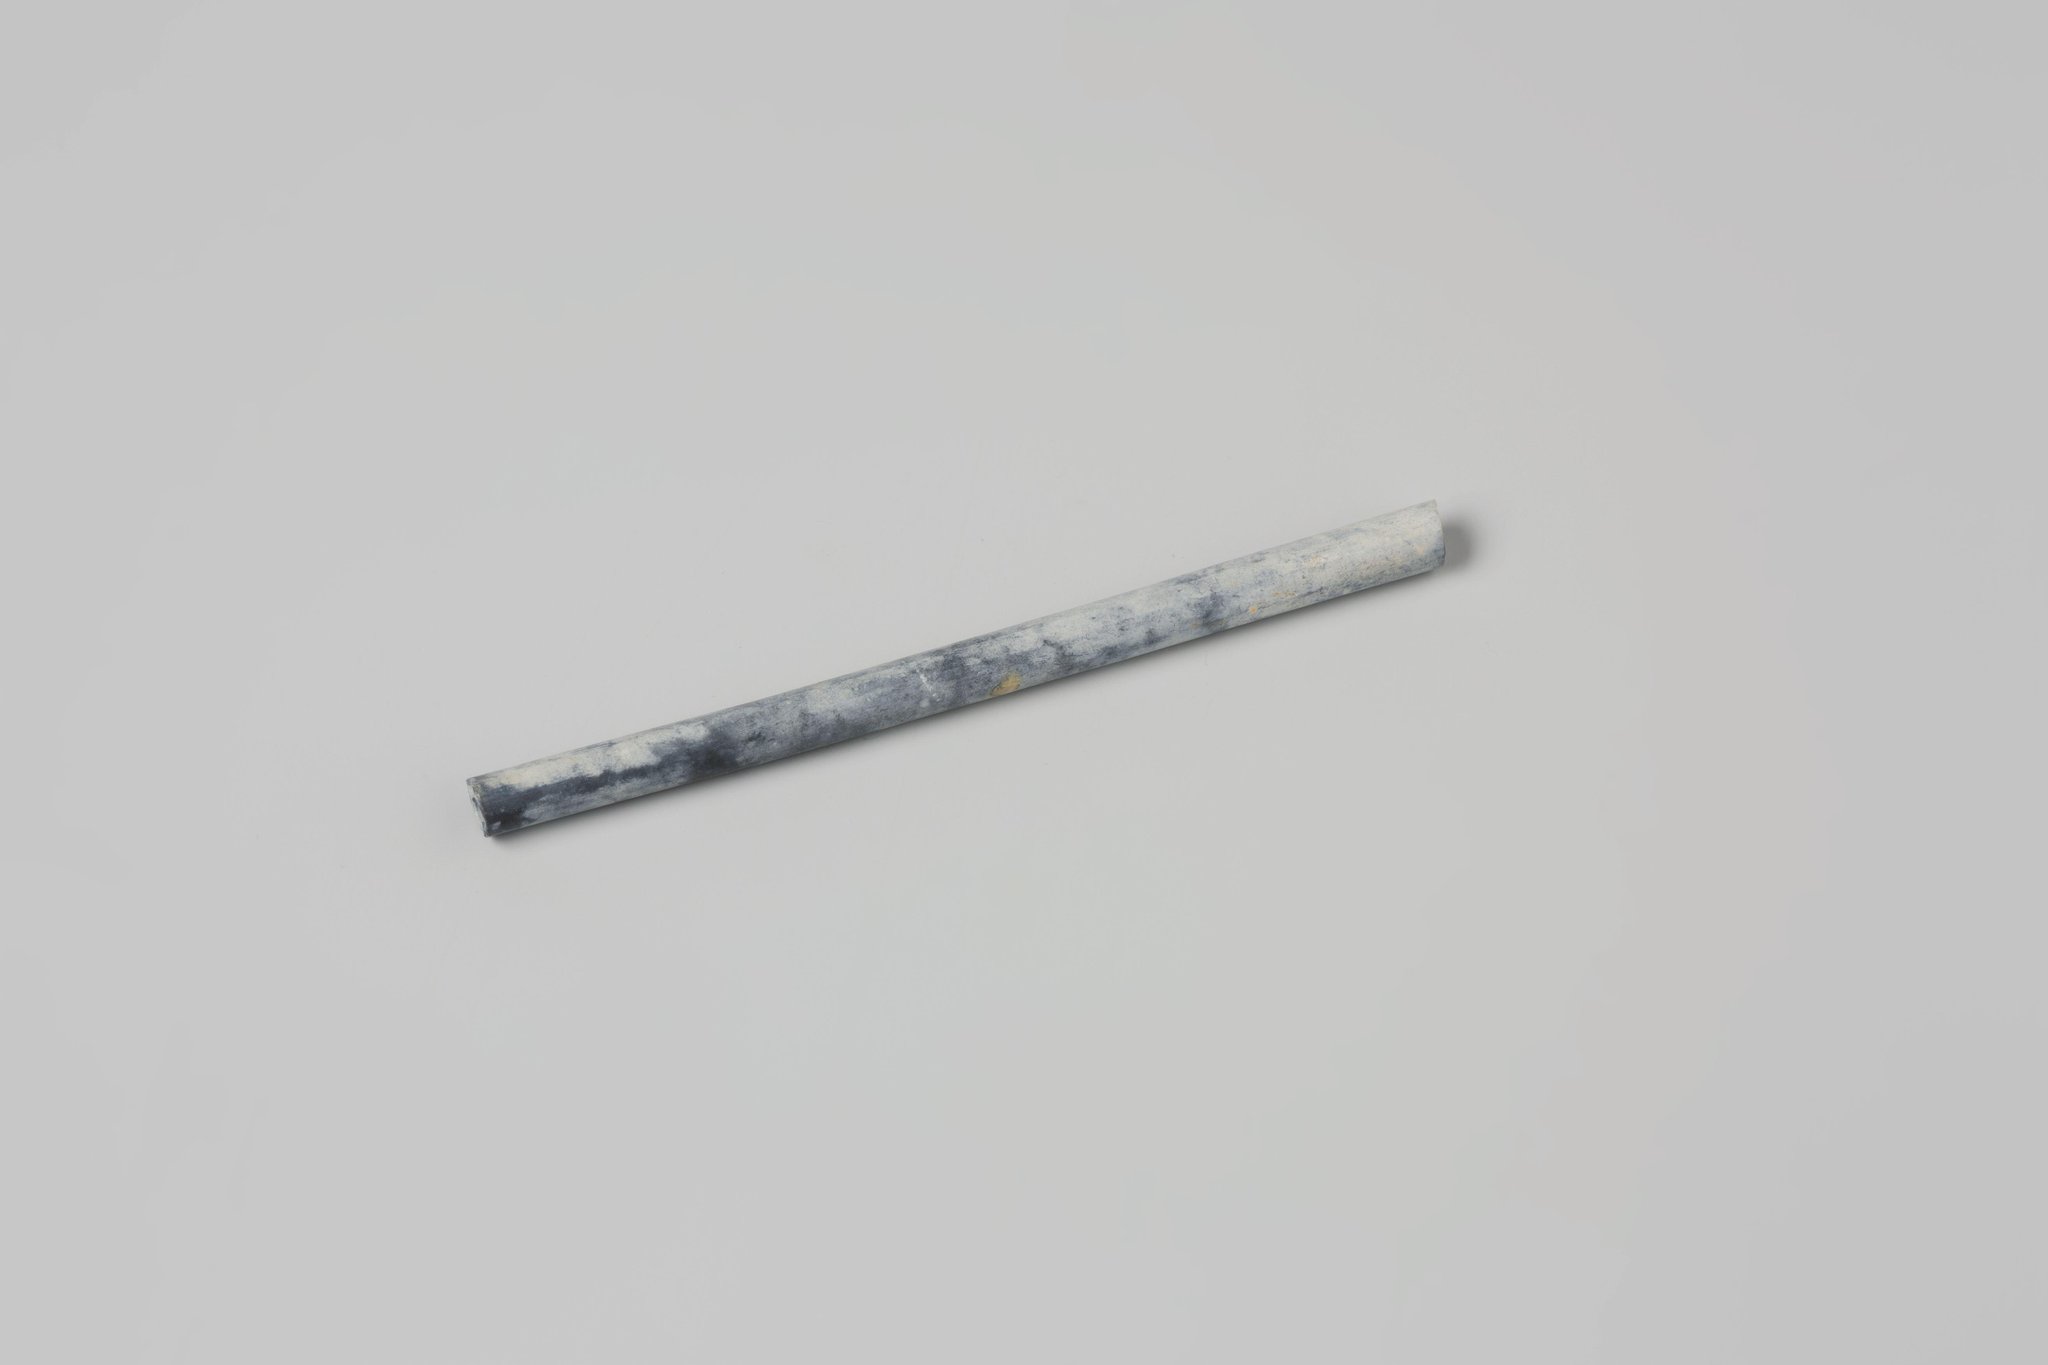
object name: pipe stem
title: Fragment van een pijpensteel uit het wrak van de Oost-Indiëvaarder 't Vliegend Hart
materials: clay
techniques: firing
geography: gouda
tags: 't vliegend hart (schip), verenigde oostindische compagnie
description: Deel van een steel van een aarden Goudse pijp, blauw-wittig van kleur. Fragments of bowls and stems.